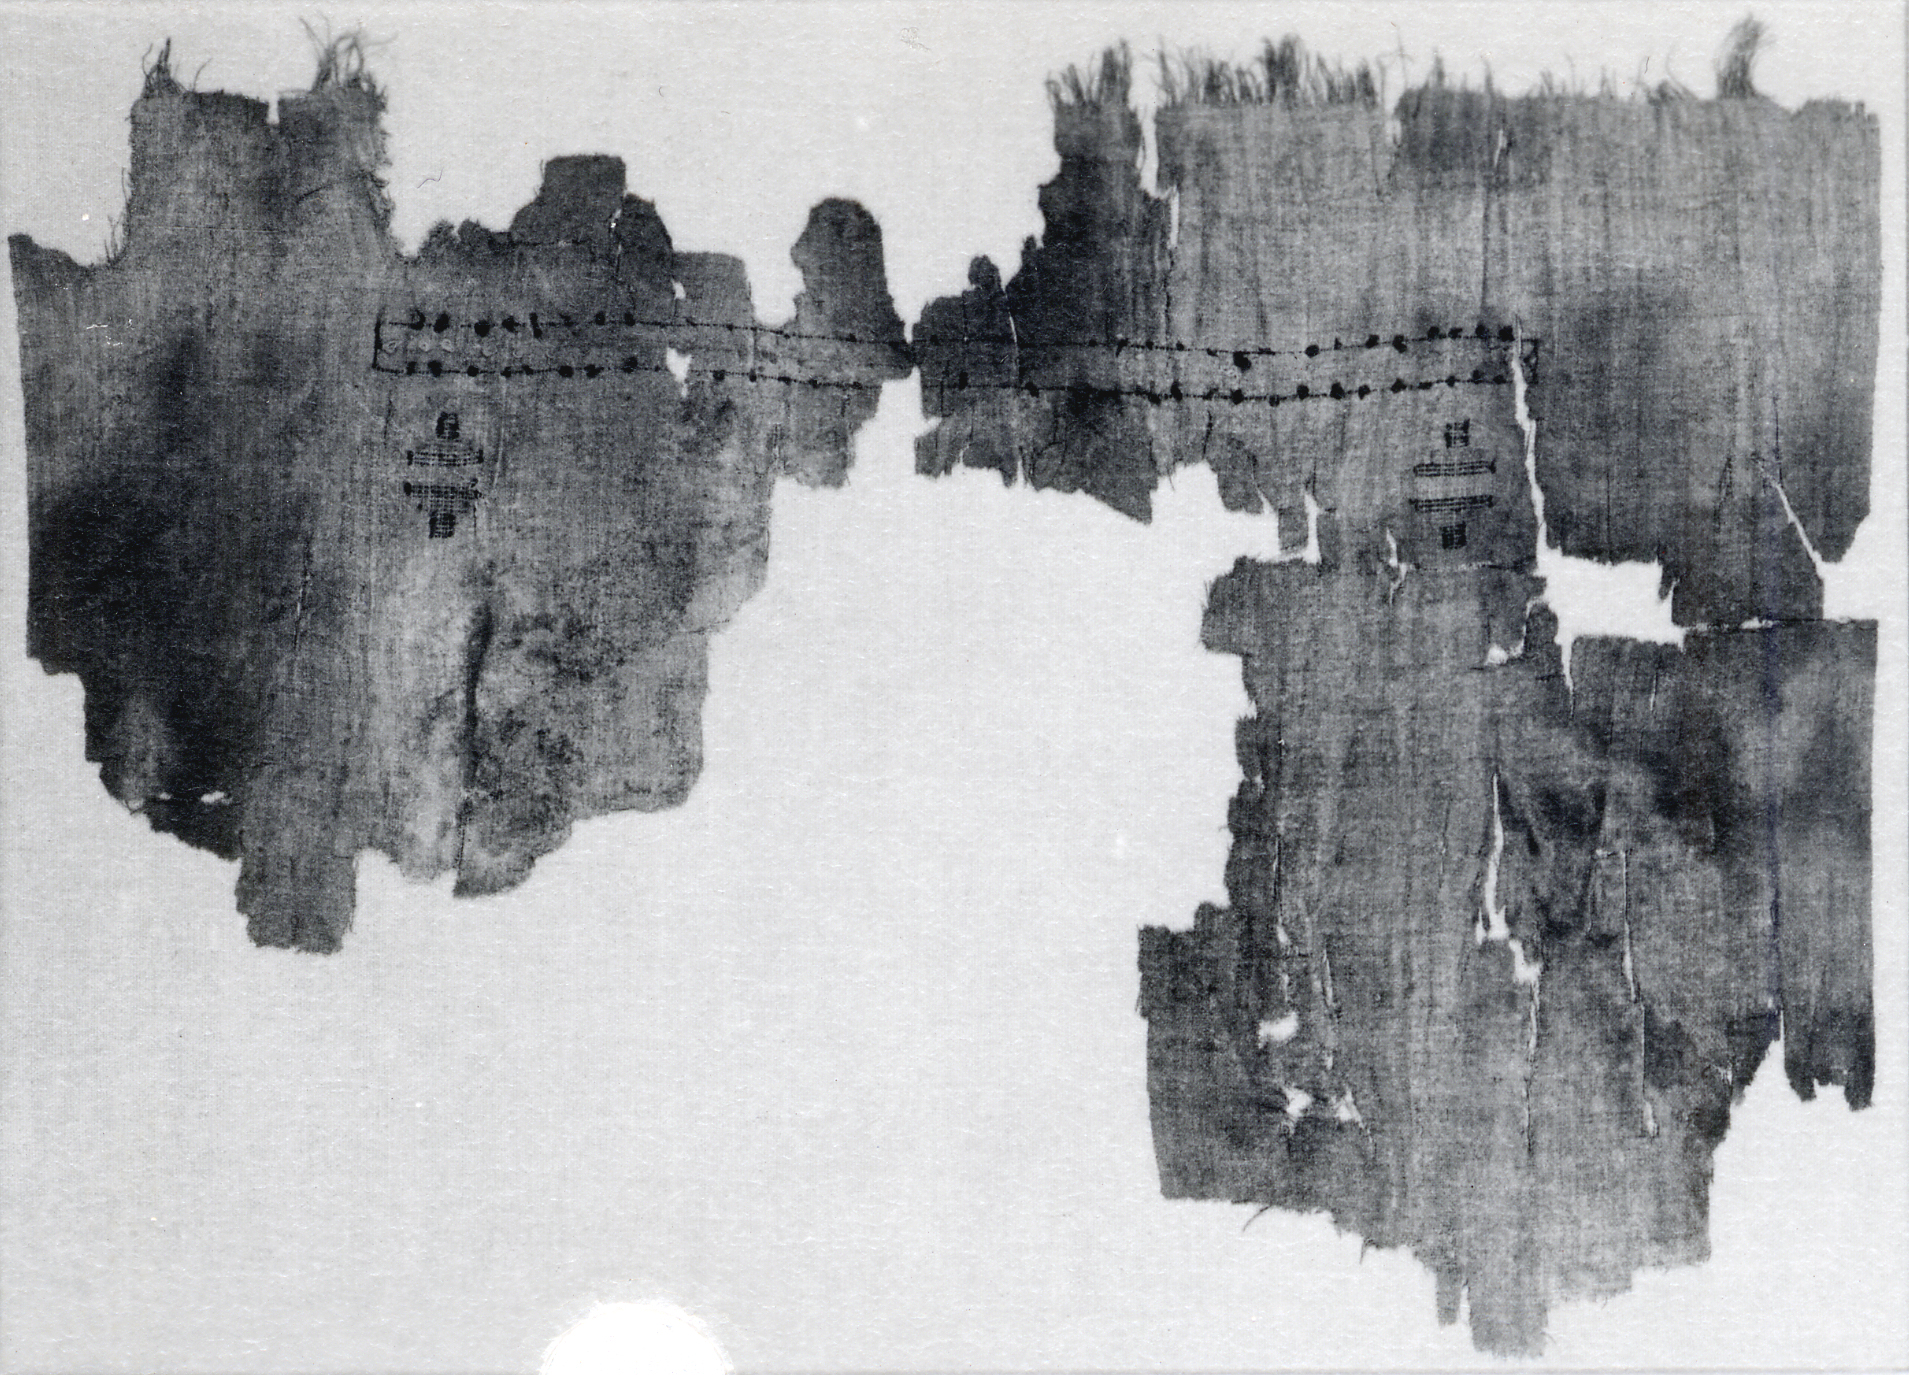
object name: fragment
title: Sheet Fragment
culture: coptic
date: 301-400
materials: linen, wool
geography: egypt